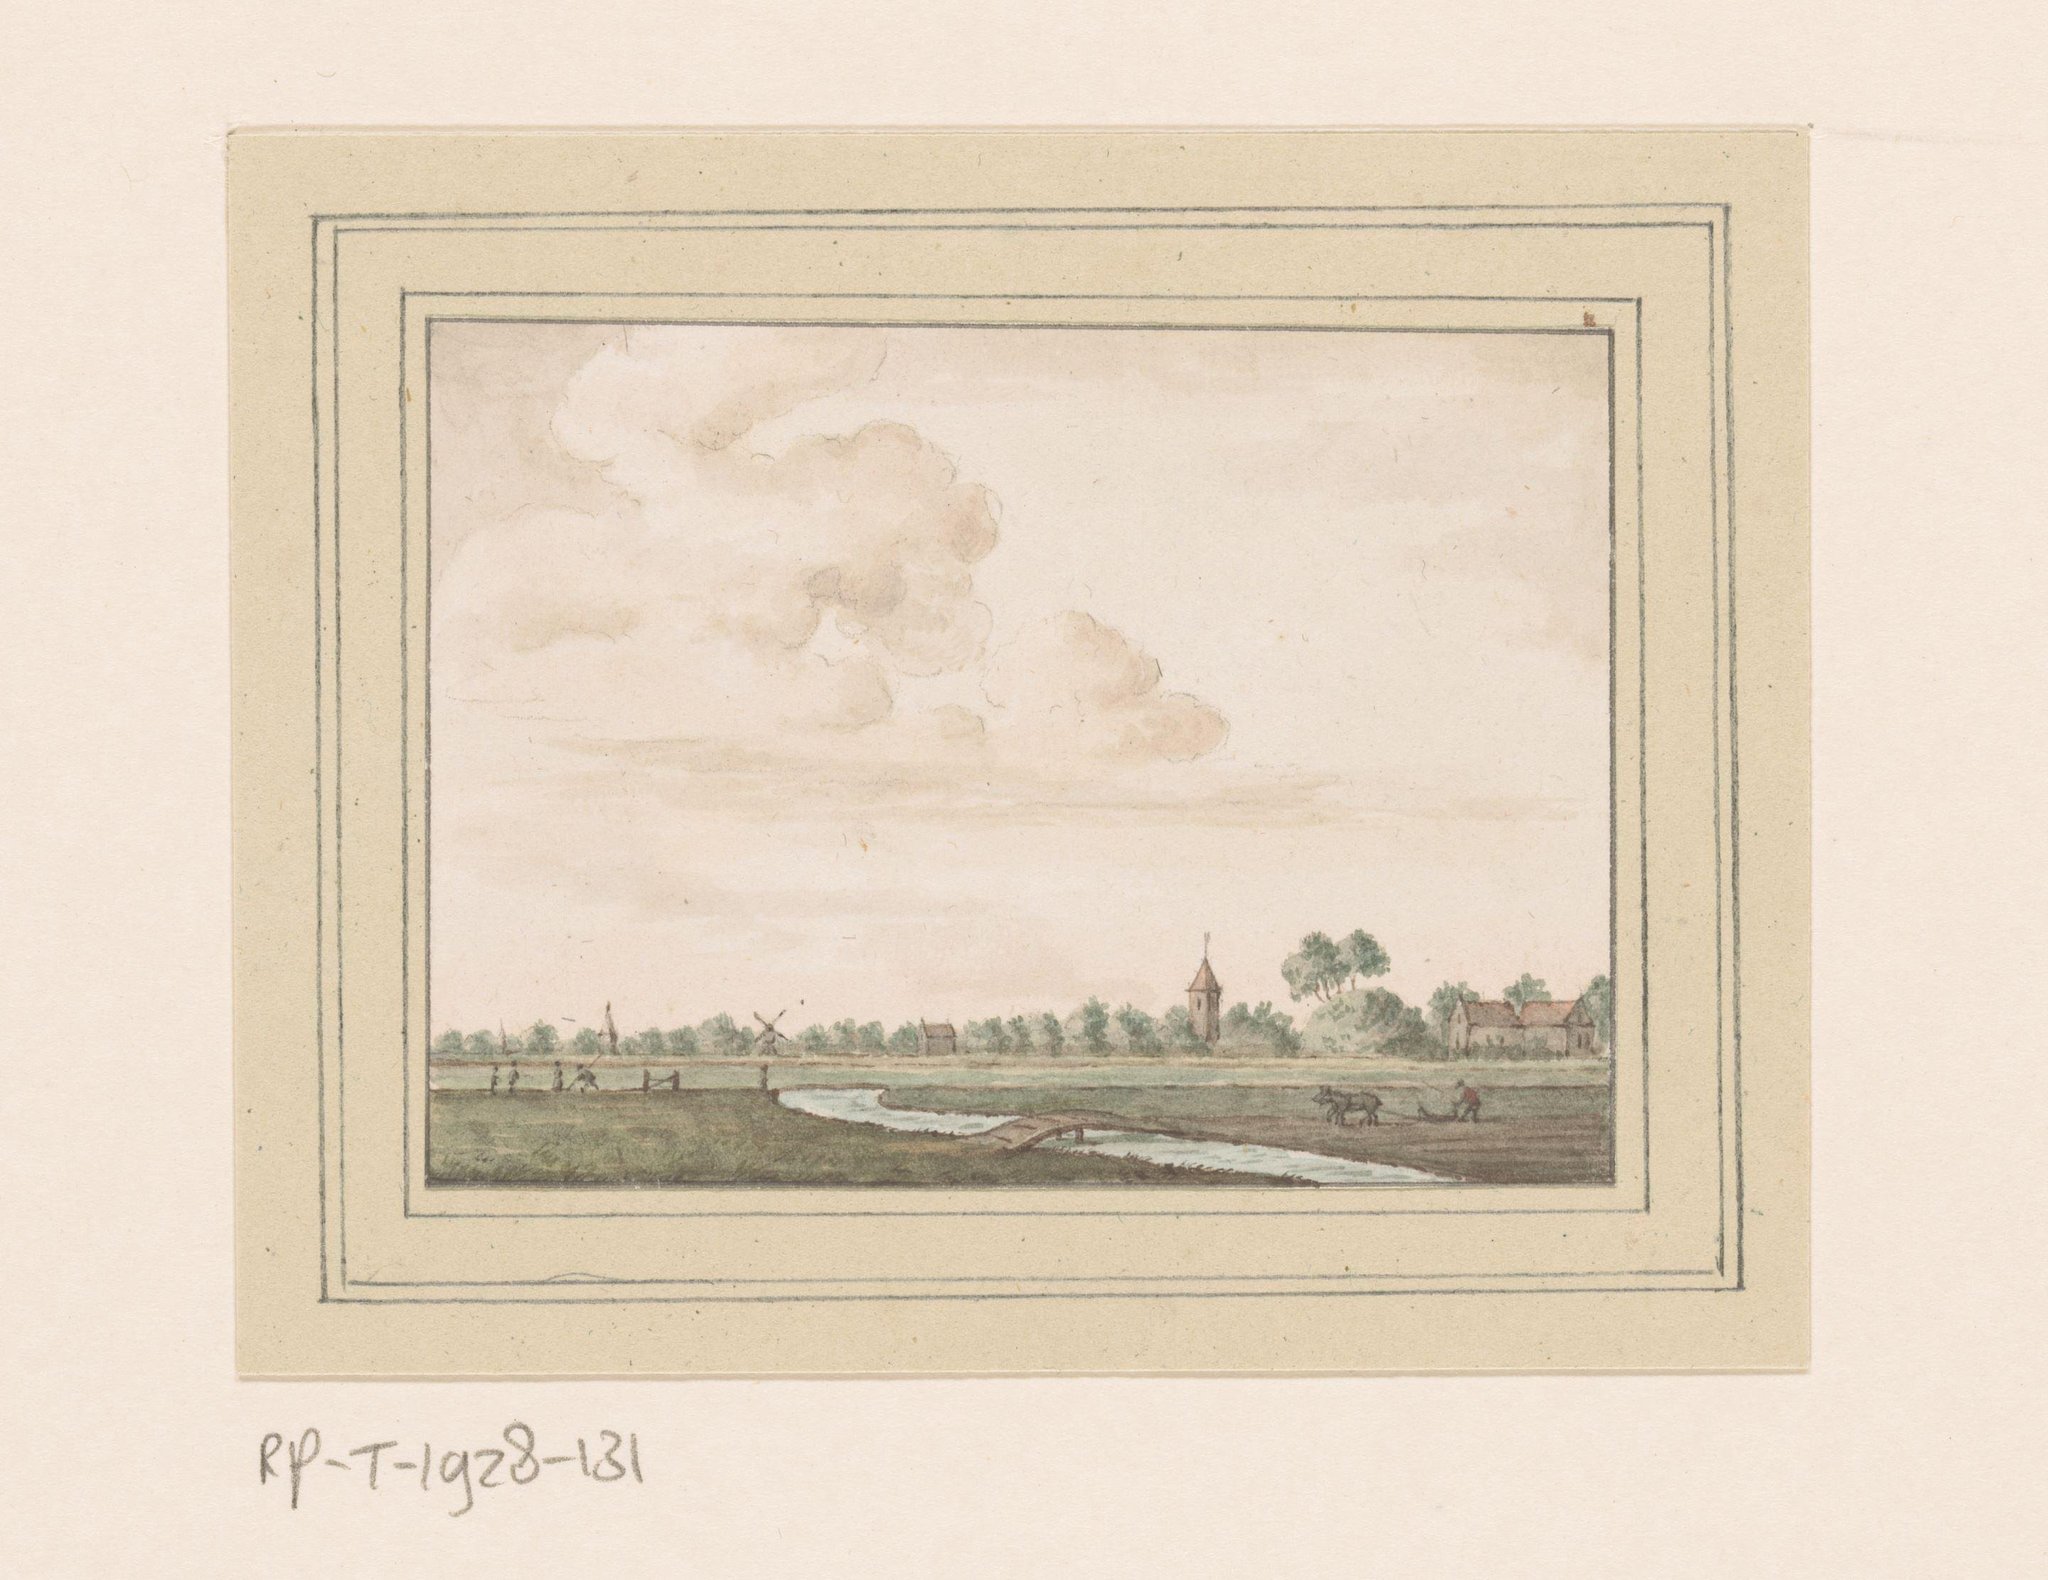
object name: drawing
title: Gezicht op Noordwelle in Zeeland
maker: Anonymous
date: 1754-1800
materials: ink, paper, pencil, watercolor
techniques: brush, pen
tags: prospect of village, silhouette of village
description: Kopie naar de prent van Hendrik Spilman, zie RP-P-AO-15-126-18-2.